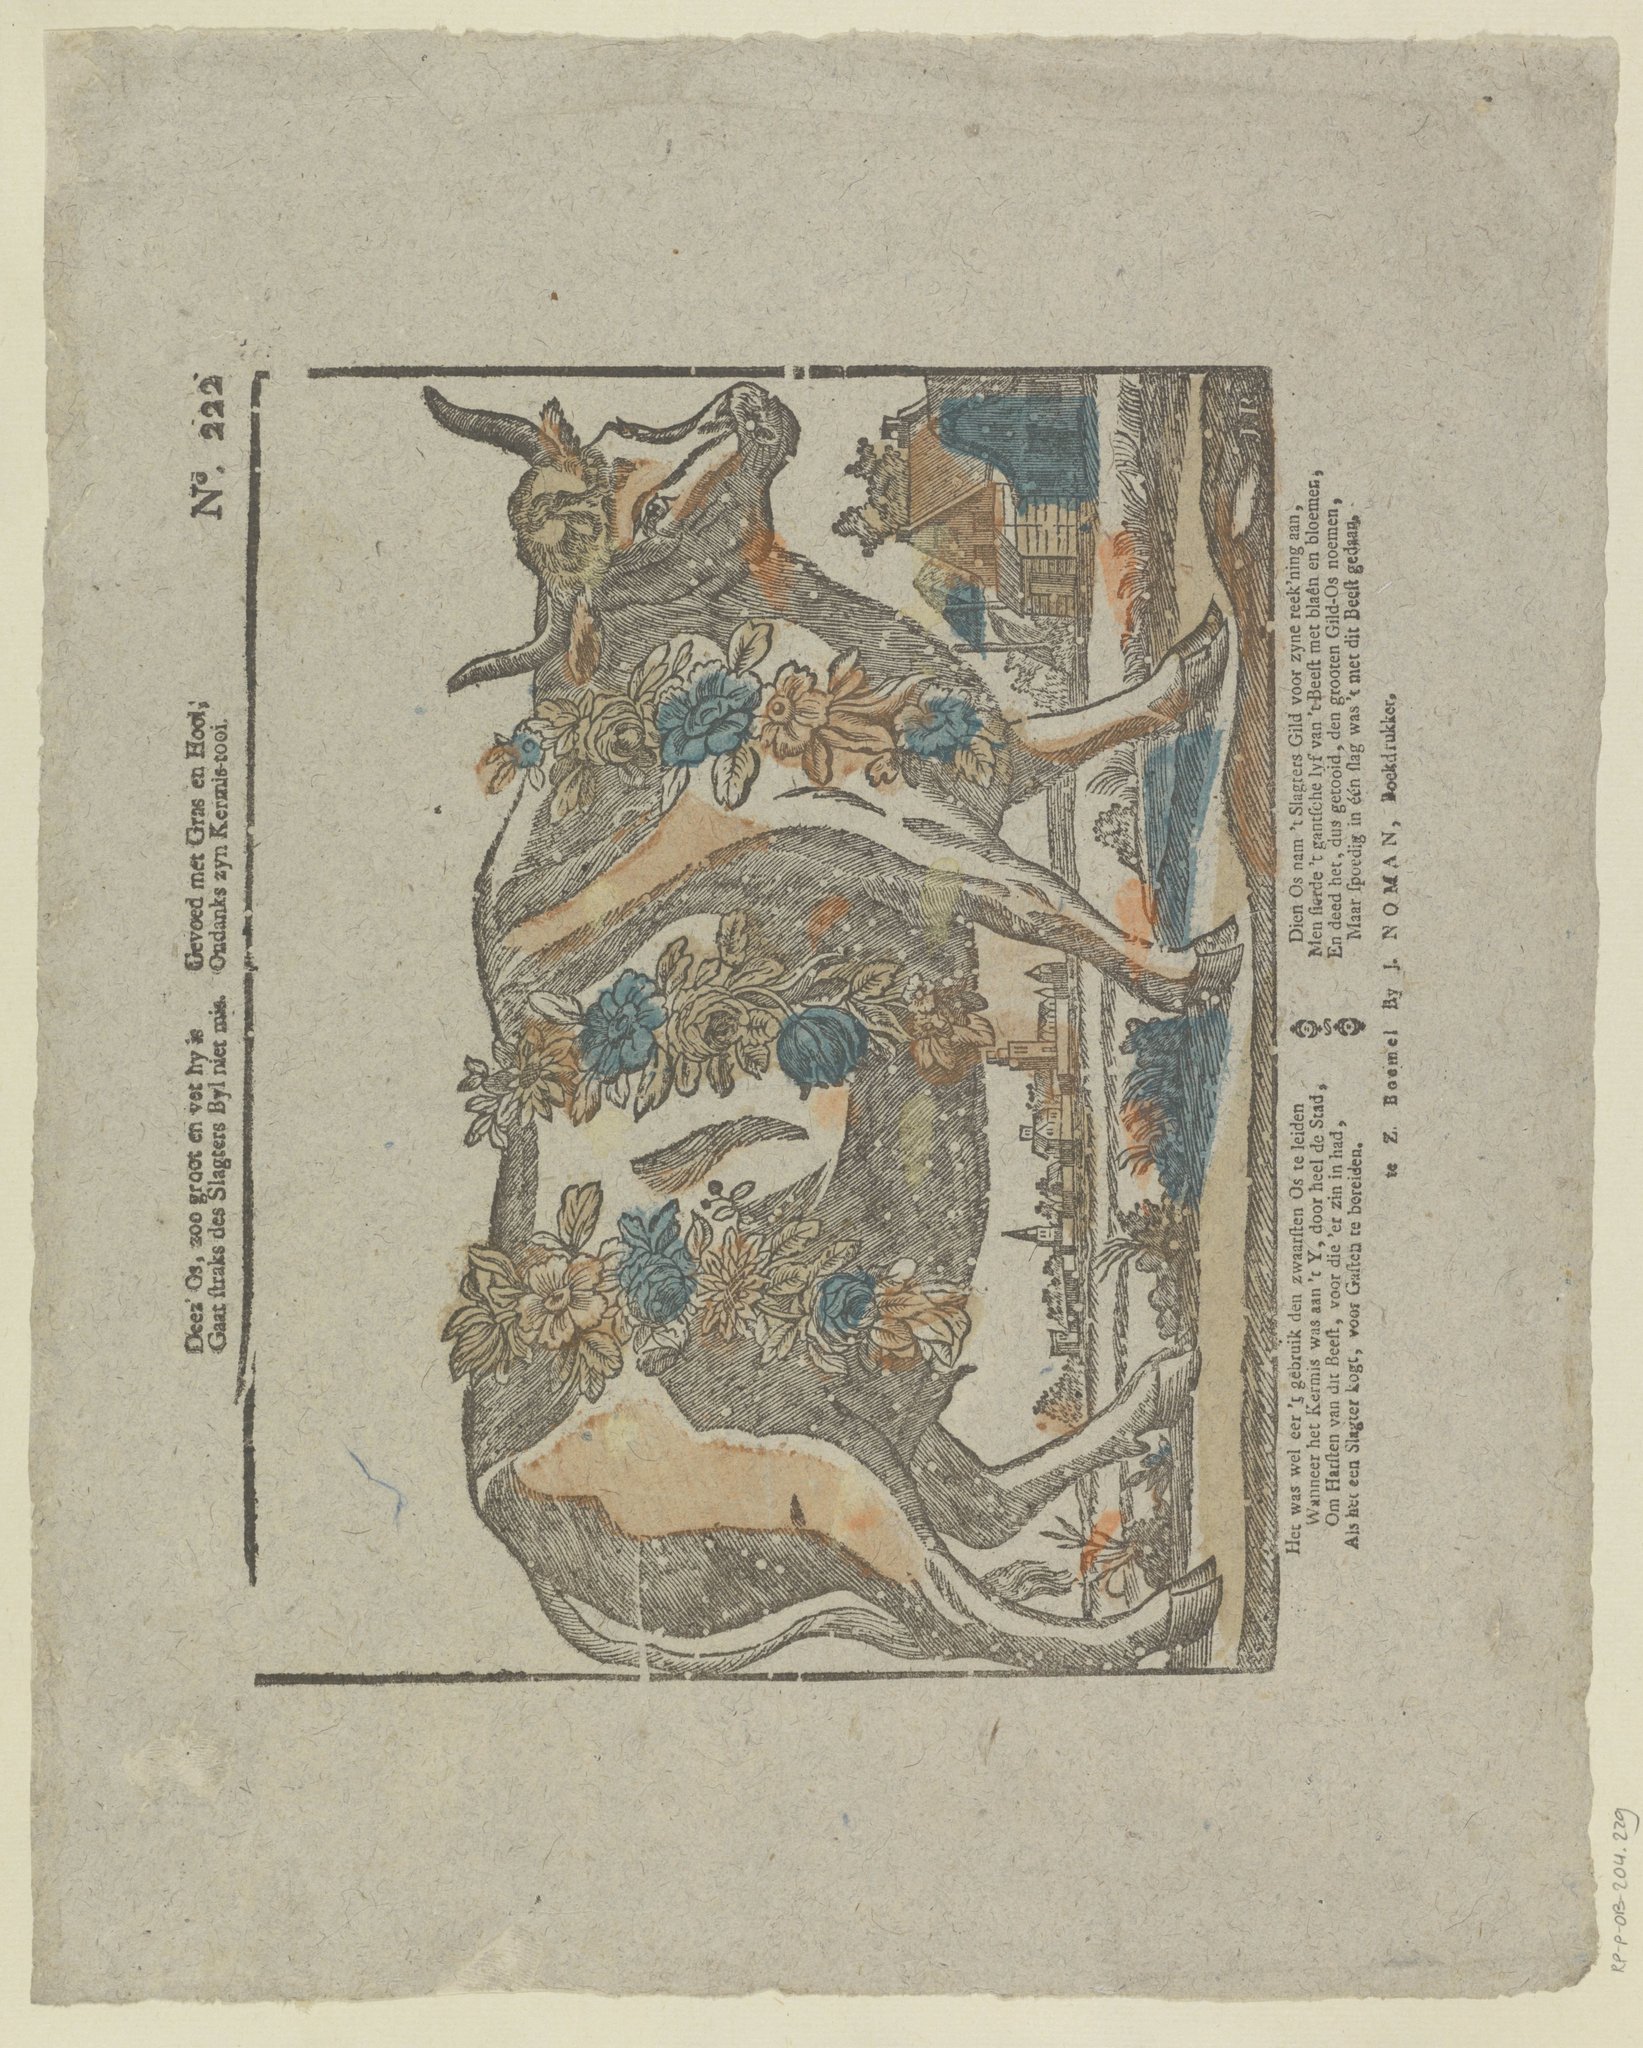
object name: print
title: Deez' os, zoo groot en vet hy is / Gevoed met gras en hooi, / Gaat straks des slagters byl niet mis. / Ondanks zyn kermis-tooi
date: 1806-1830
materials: paper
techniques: colour, letterpress printing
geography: netherlands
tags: prize-ox, ox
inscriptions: collector's mark: Lugt 2760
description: Blad met een grote voorstelling van een gilde-os (ook kermisos of prijsos genoemd), versierd met bloemenkransen. Onder de afbeelding een vers in twee kolommen. Genummerd rechtsboven: No. 222.